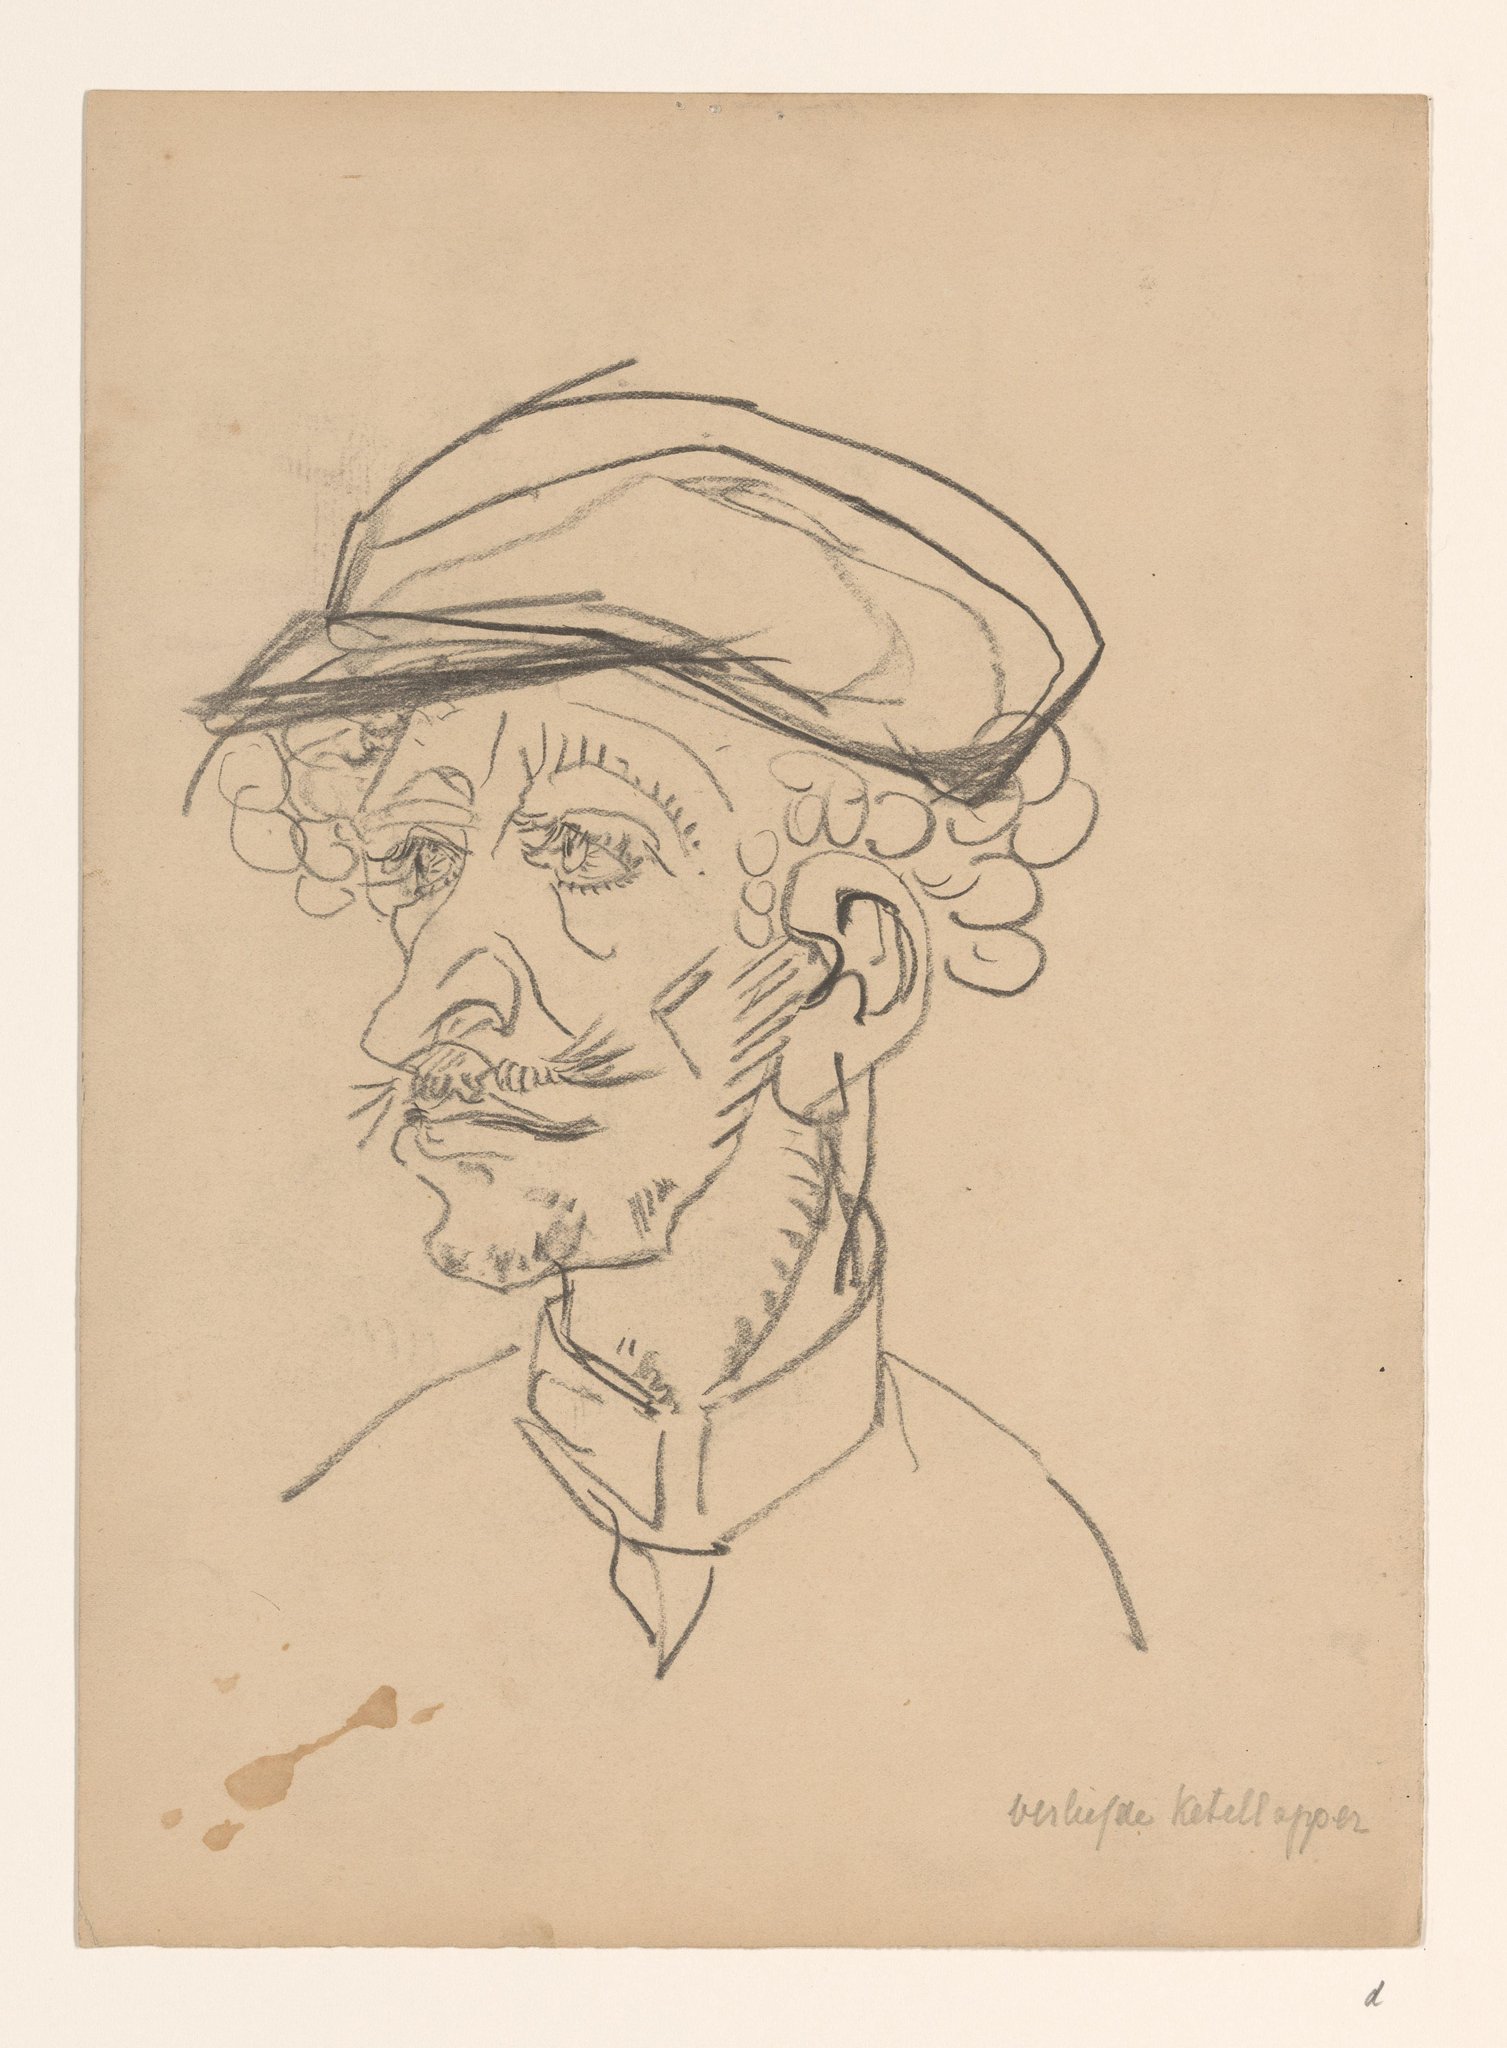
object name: drawing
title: Verliefde ketellapper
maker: wilhelmus johannes steenhoff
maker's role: draughtsman, print maker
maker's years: 1863-1932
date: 1873-1932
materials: chalk, paper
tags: handicrafts ~ maintenance and repair, caricatures (human types), container of metal: bucket, can, canister, drum, tin